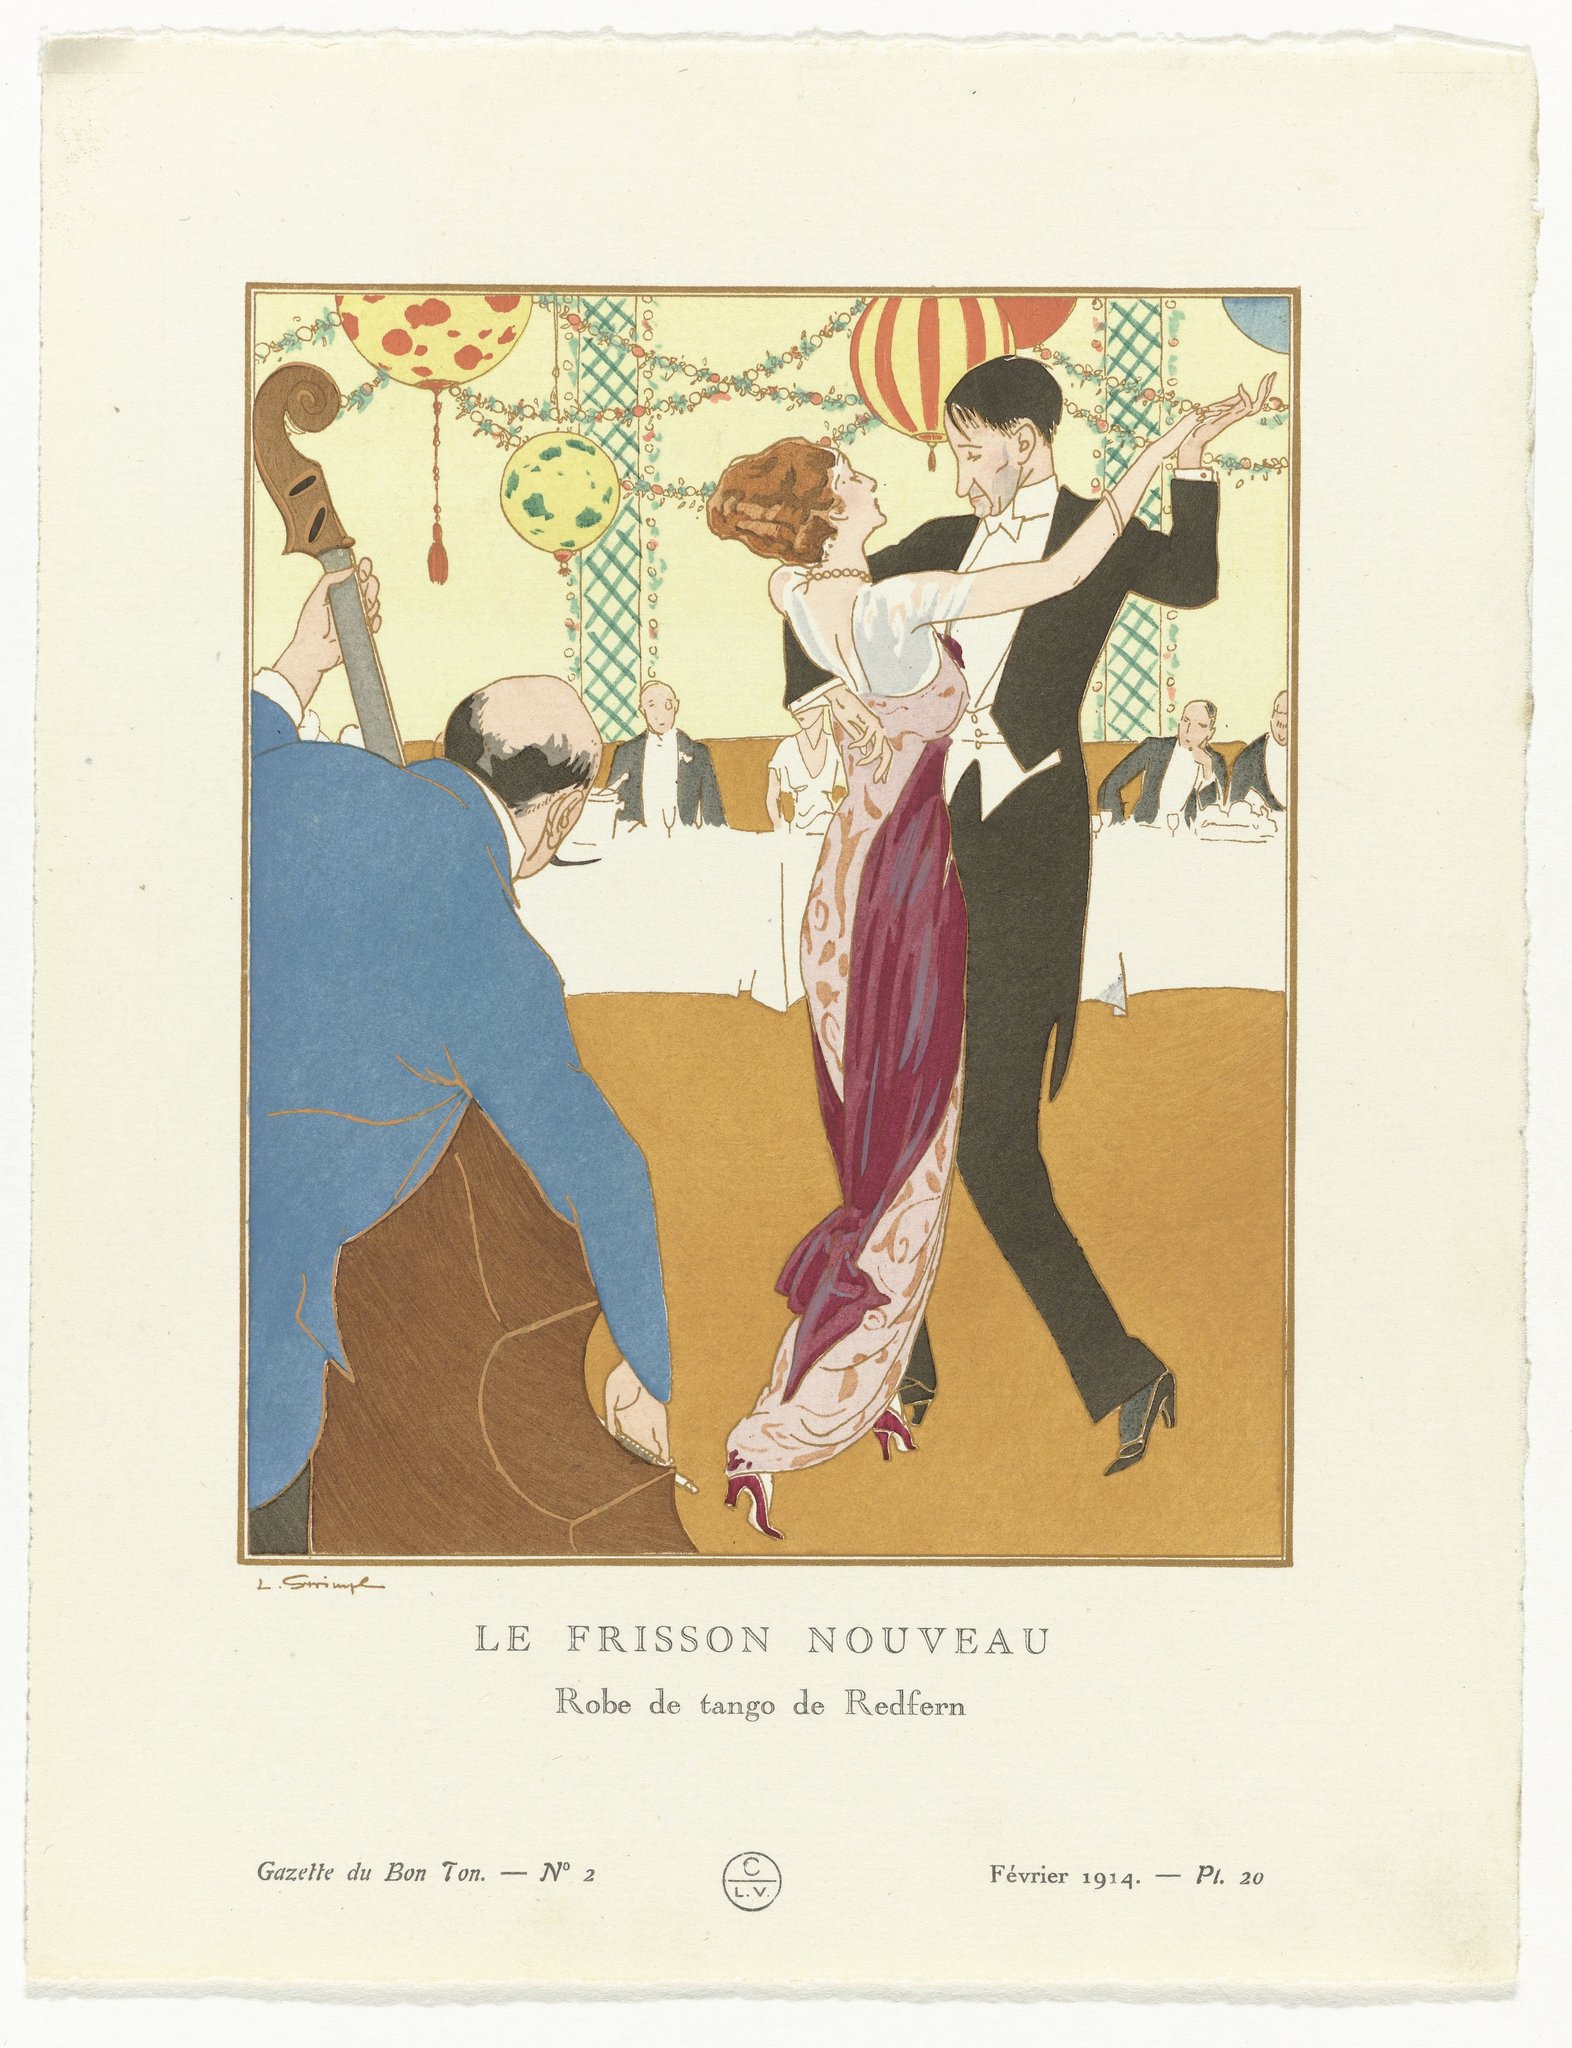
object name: fashion print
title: The new Thrill: Tango Dress by Redfern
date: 1914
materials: paper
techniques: hand coloring, letterpress printing, lithograph, pochoir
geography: paris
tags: ensembles of pieces of clothing (suit) (+ men's clothes), viola, violoncello; double bass (+ artist at work), one pair dancing; man and woman dancing as a couple, fashion plates, dress, gown (+ women's clothes)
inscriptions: caption: ‘LE FRISSON NOUVEAU / Robe de tango de Redfern.’, inscription: ‘Gazette du Bon Ton. - No 2 / Février 1914. - Pl. 20’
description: If the price of the Gazette du Bon Ton was steep, that of the clothes pictured was exorbitant. Evening attire was especially luxurious, consisting chiefly of silk garments decorated with gold and silver thread or expensive fur. Naturally, clothes like these called for costly accessories, which a true lady wore sparingly. An outfit had to work as a whole: all of the details, from headbands to high-heeled shoes, had to fit together. And that, in turn, required money, time, care and, most importantly, bon ton (good taste).